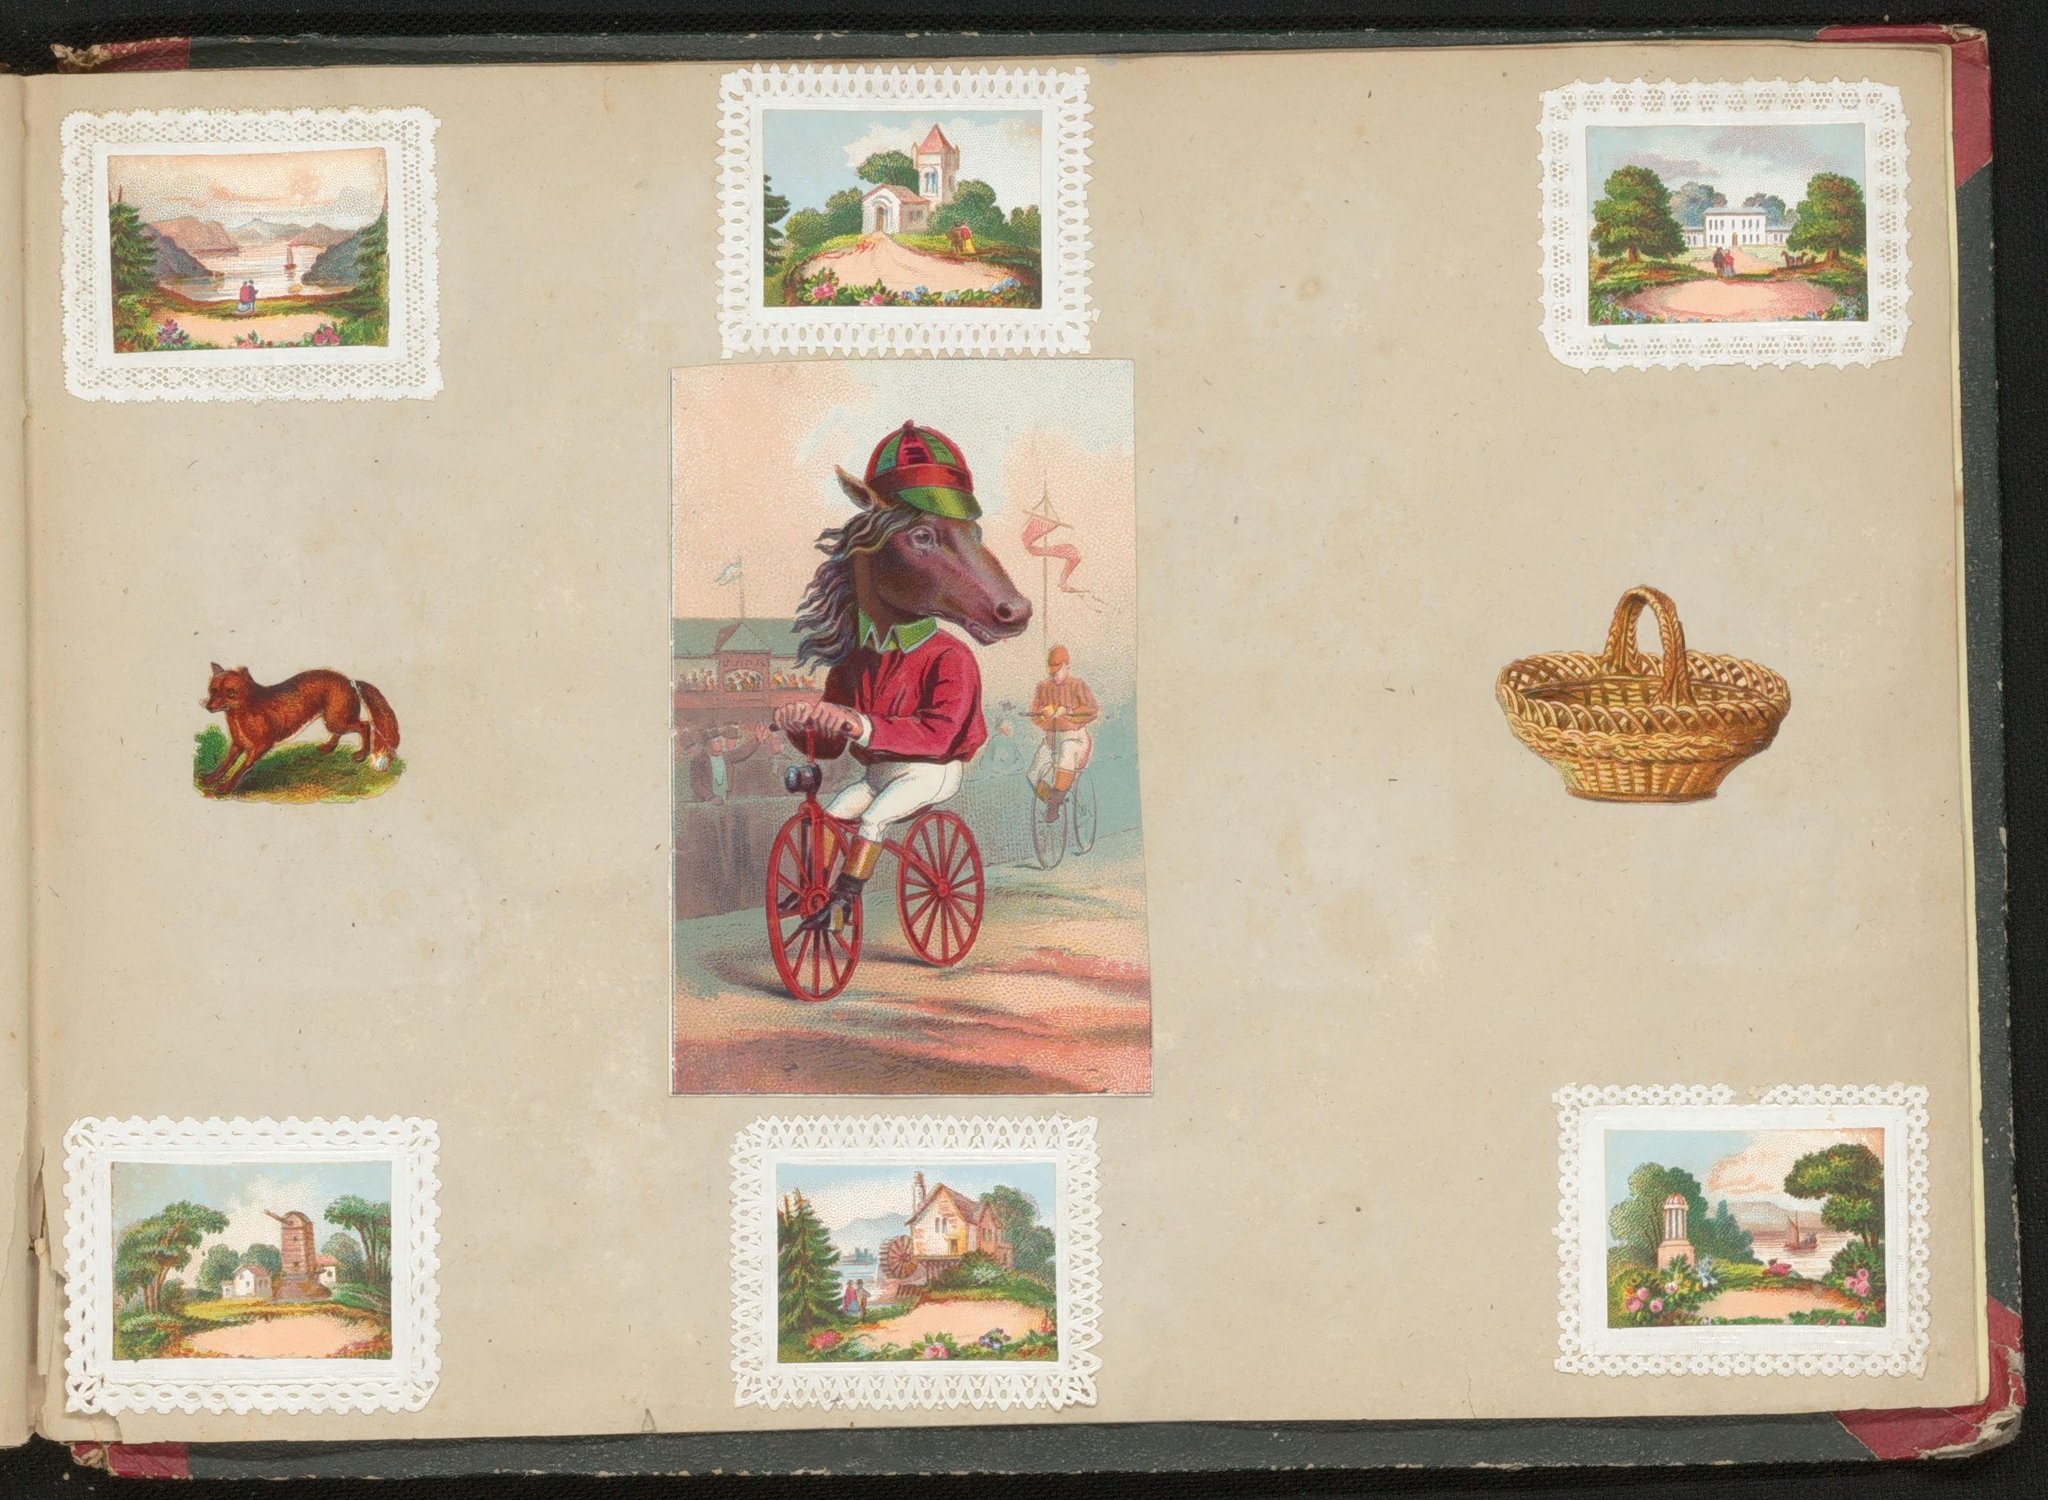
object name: album leaf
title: Albumblad met 9 plakplaatjes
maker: Anonymous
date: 1880-1910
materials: paper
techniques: chromolithography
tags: animals acting as human beings, bicycle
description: Albumblad met 9 plakplaatjes, centraal een paard op een fiets. Onderdeel van het plakboek met 38 bladen gevuld met plakplaatjes, poesieplaatjes en uitgeknipte en ingeplakte fragmenten van prenten. Onderwerpsrubrieken binnen de Atlas Zeden en Gewoonten: Schoone kunsten, Varia.